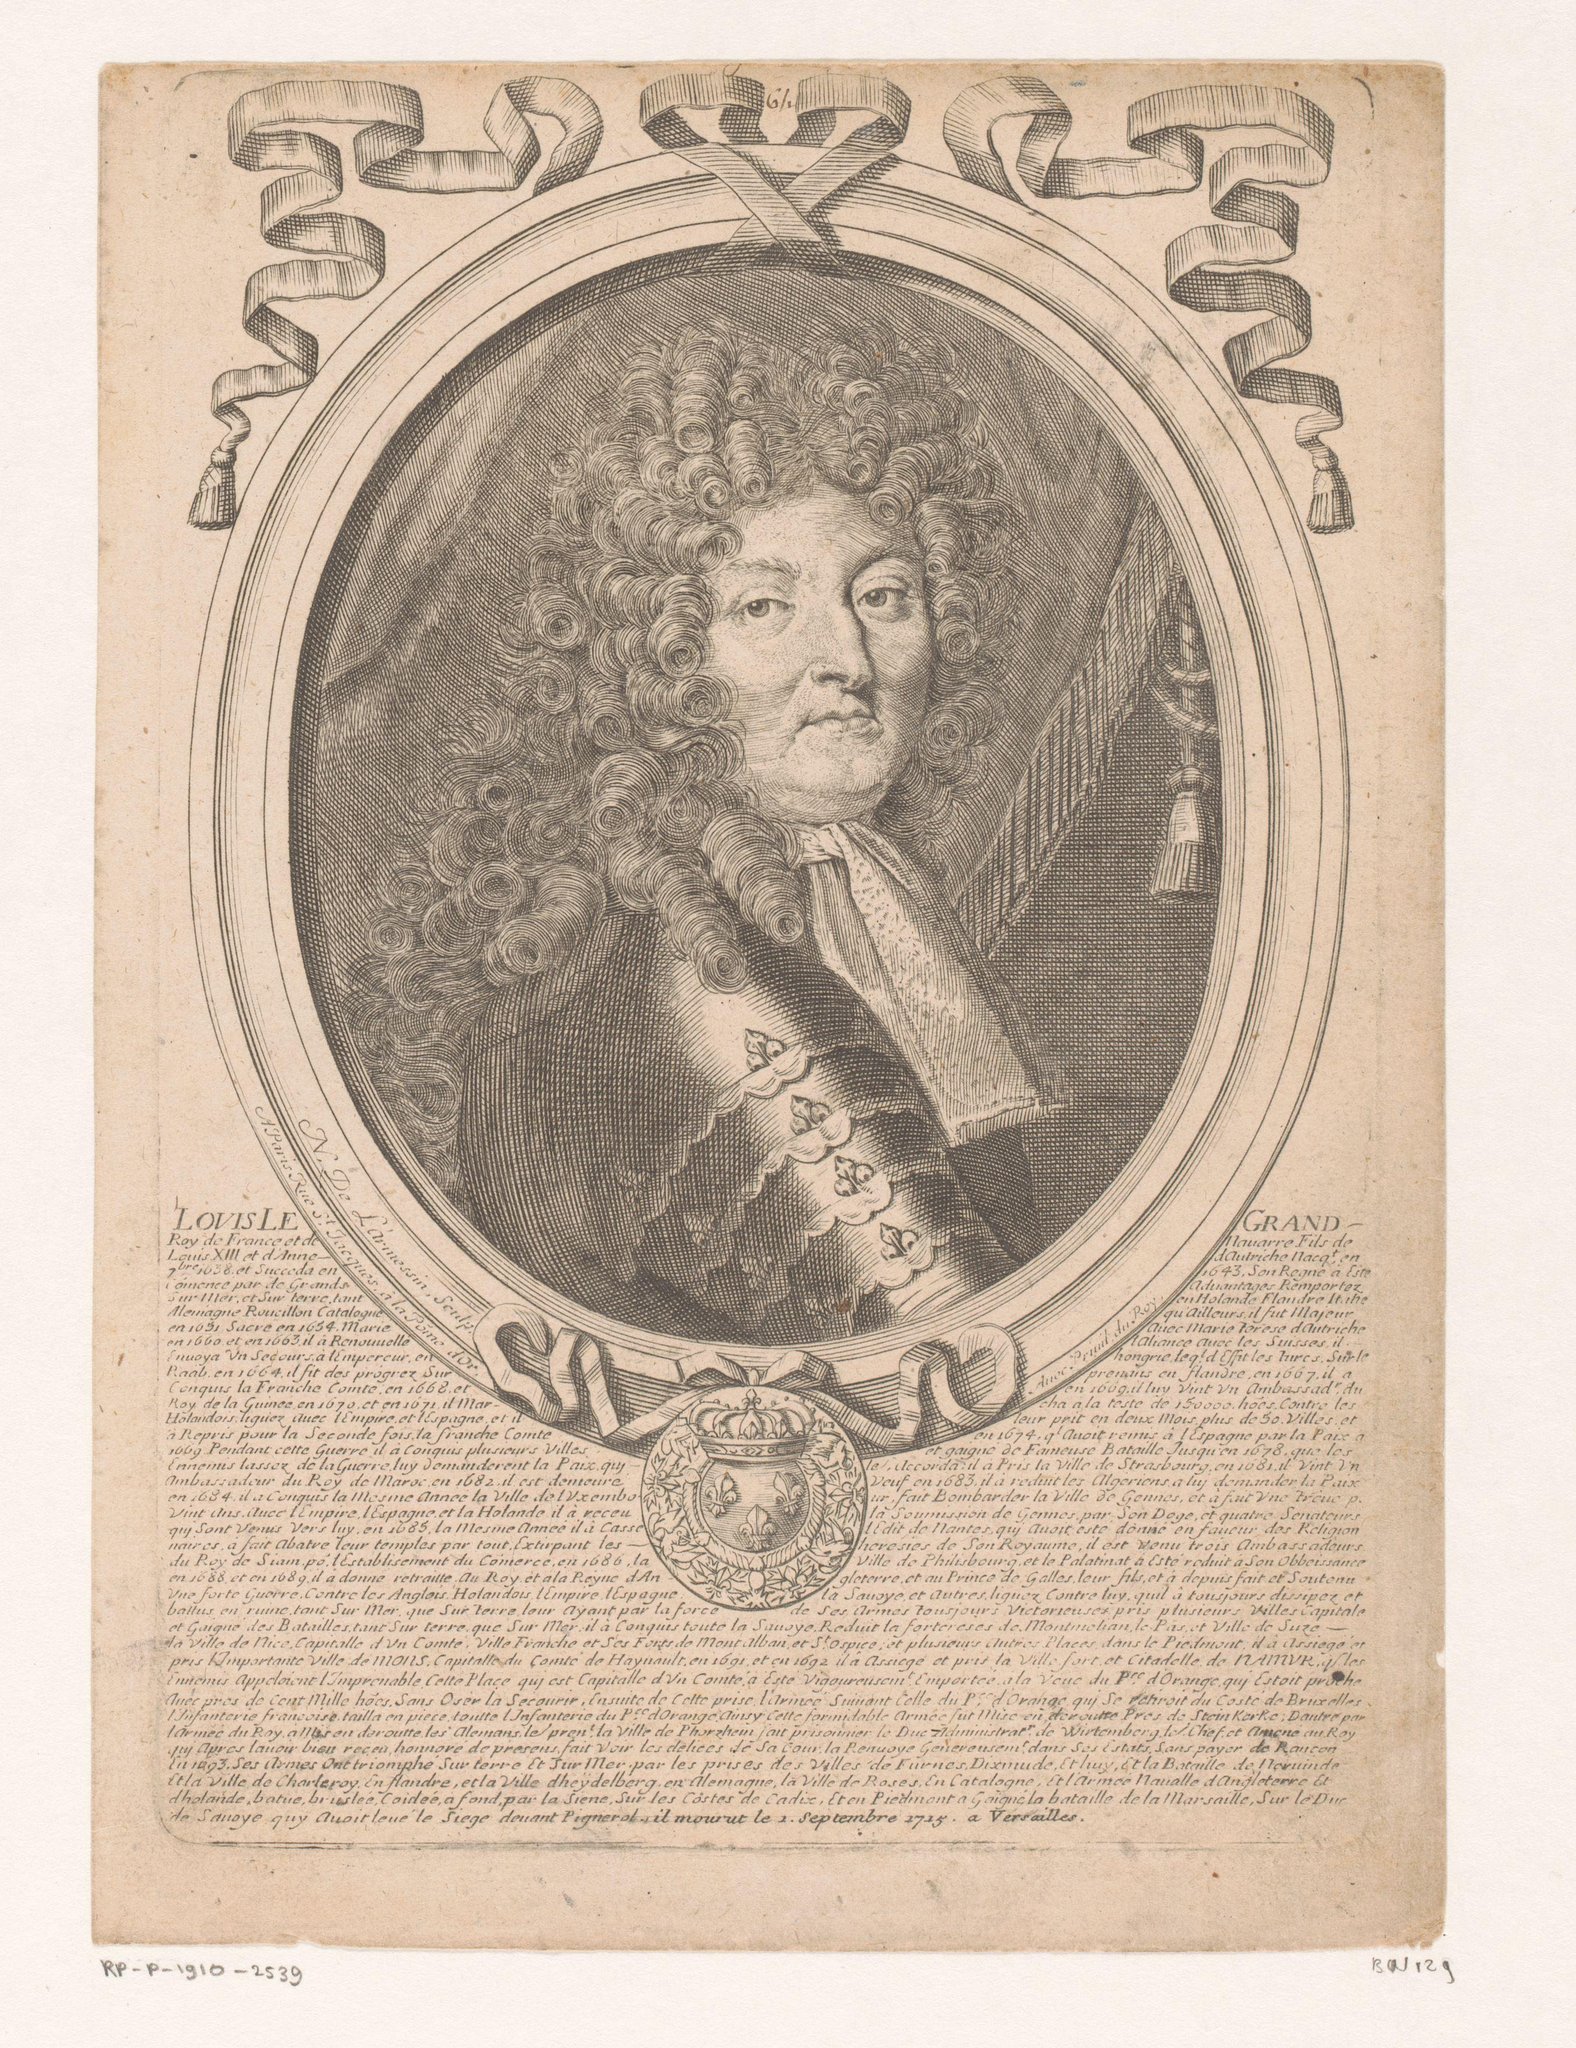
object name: print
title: Portretten van prominente figuren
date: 1642-1725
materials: paper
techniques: engraving, etching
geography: paris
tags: lodewijk xiv (koning van frankrijk), historical persons, king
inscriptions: collector's mark: Lugt 2228, number: ‘64’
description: Maakt deel uit van een grootschalige serie met portretten van prominente figuren. Binnen de serie bevindt zich een sectie getiteld 'Les Augustes Représentations De tous les Roys De France depuis Pharamond Iusqu'à Louys XIIII'. De serie werd respectievelijk uitgegeven door Pierre Bertrand, door zijn weduwe en door De Larmessin zelf.